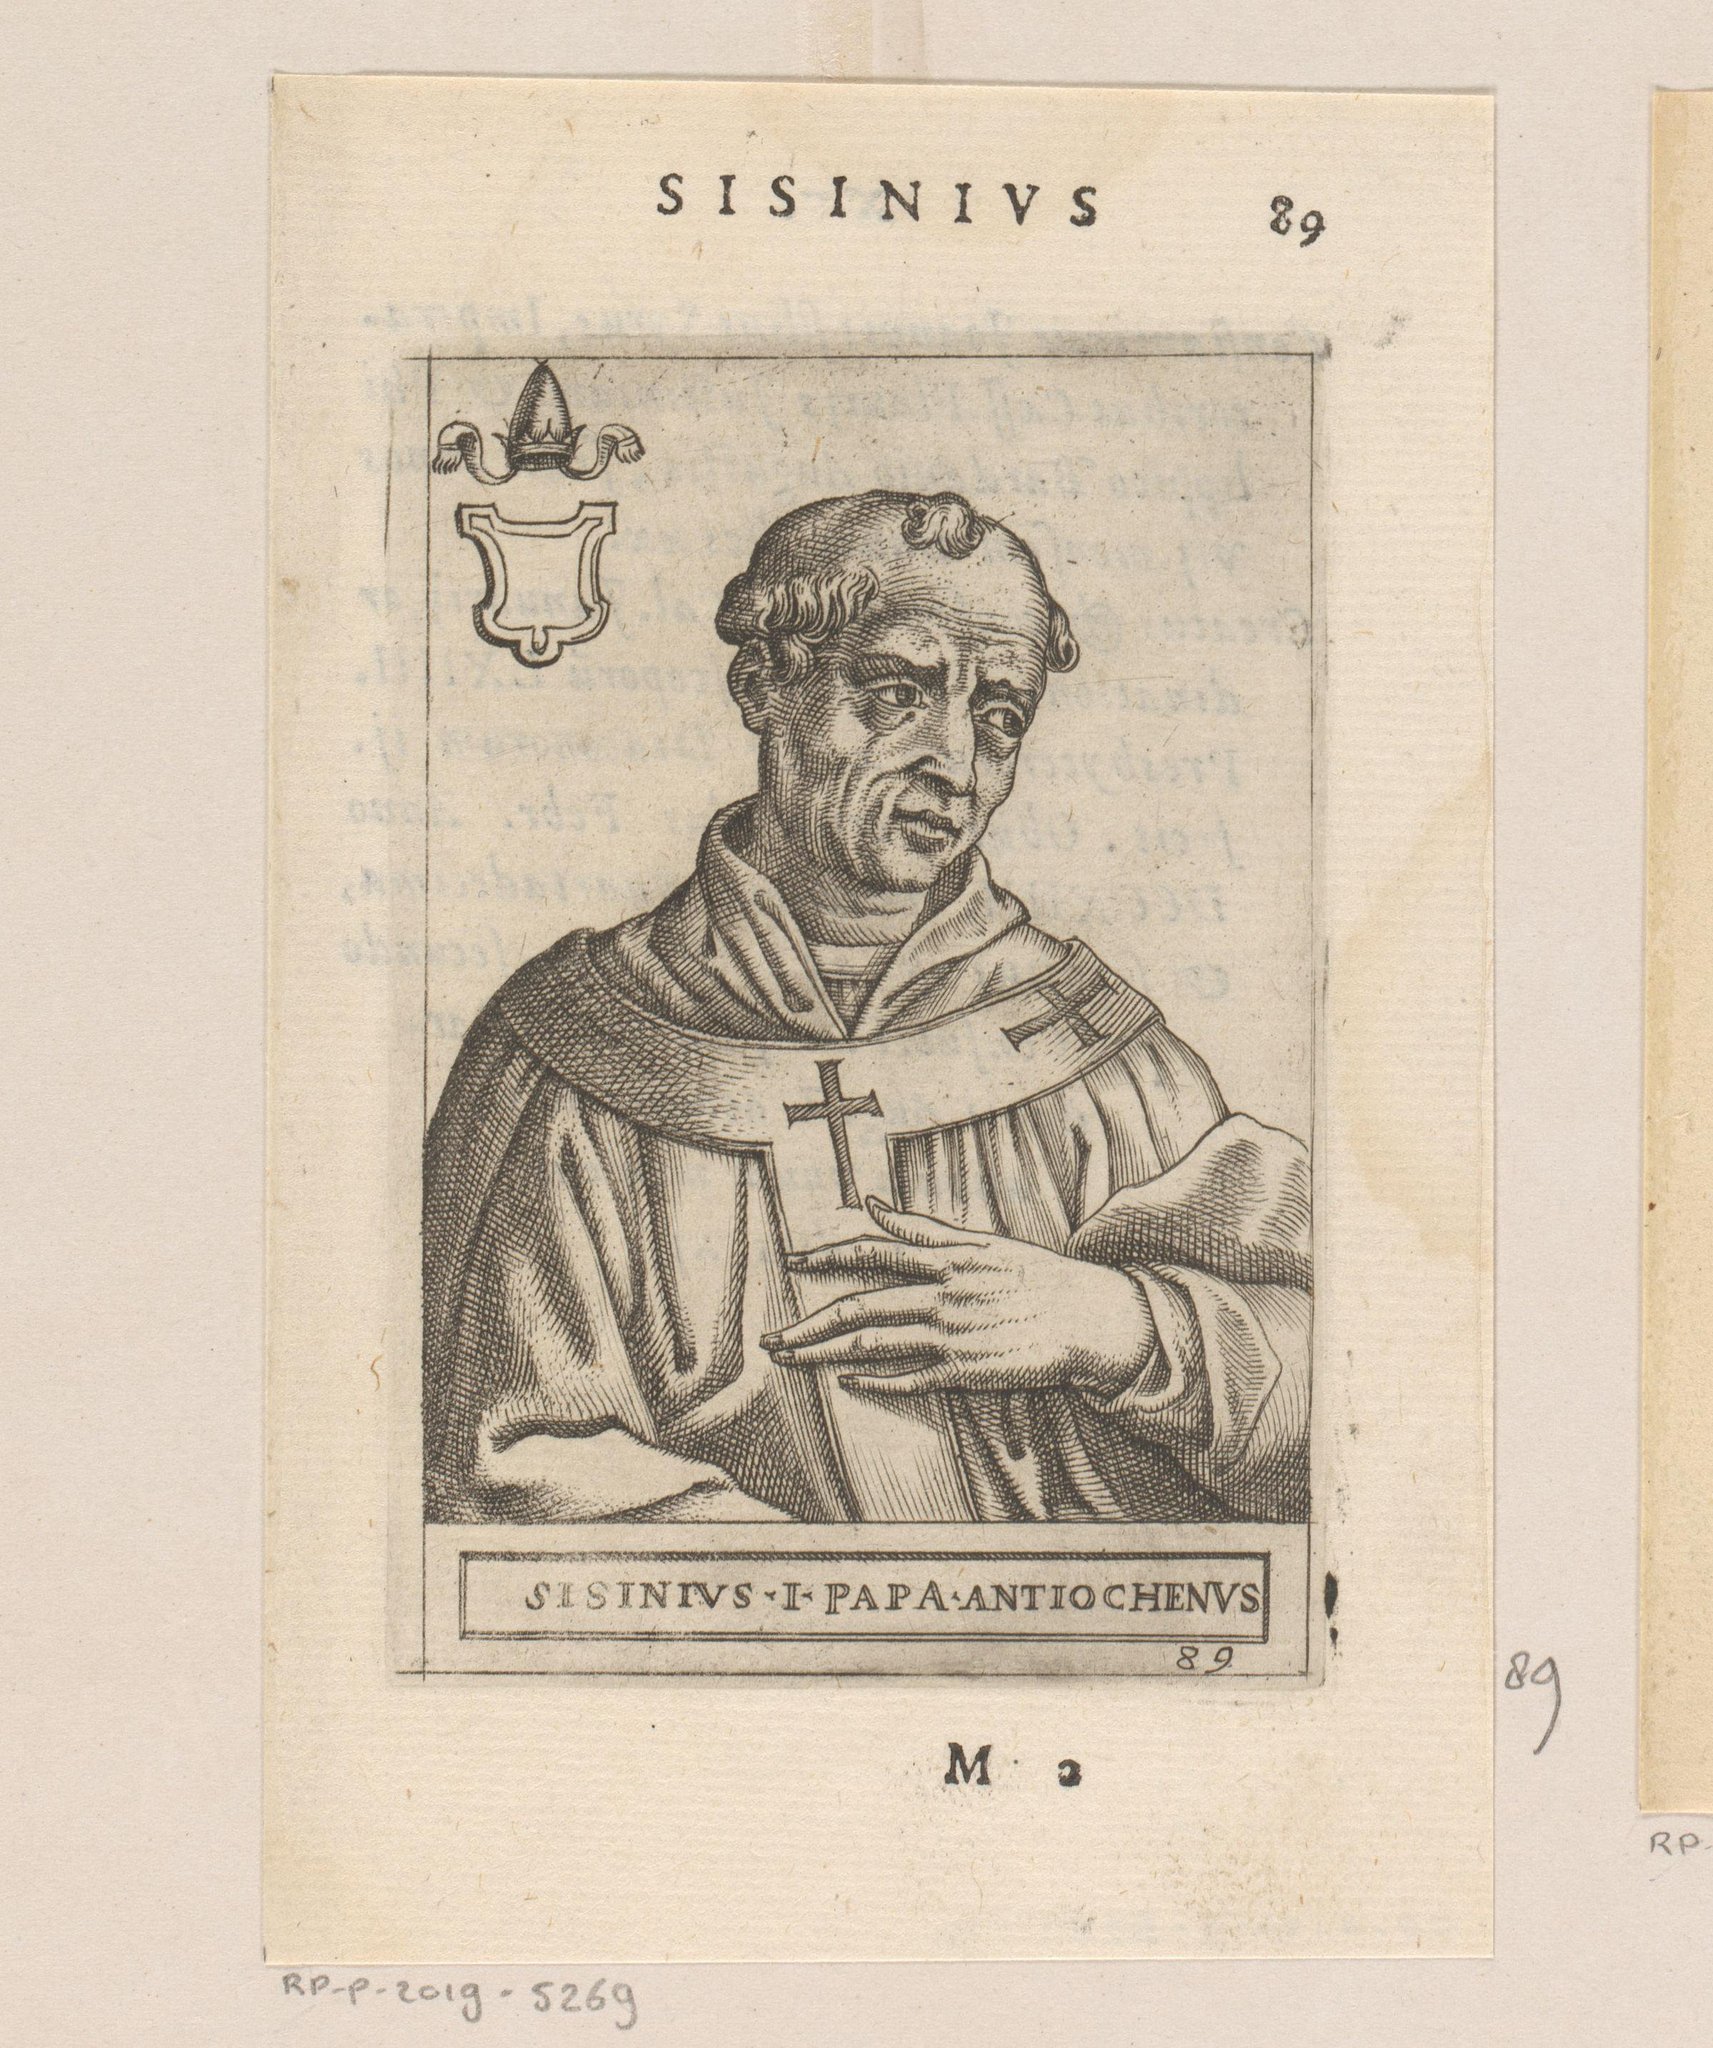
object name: book illustration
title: Portret van paus Sisinnius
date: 1595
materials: paper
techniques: engraving, letterpress printing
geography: rome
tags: historical persons, pope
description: Prent uit: Cavalieri, Giovanni Battista de'. Effigies pontificum romanorum cum eorum vitis (...). Rome: Bartolomeo Bonfadino, 1595. Prent voor het eerst verschenen in: Cavalieri, Giovanni Battista de'. Pontificum romanorum effigies (...). Rome: Domenico Basa en Francesco Zanetti, 1580. Prent ook gebruikt in latere publicaties.